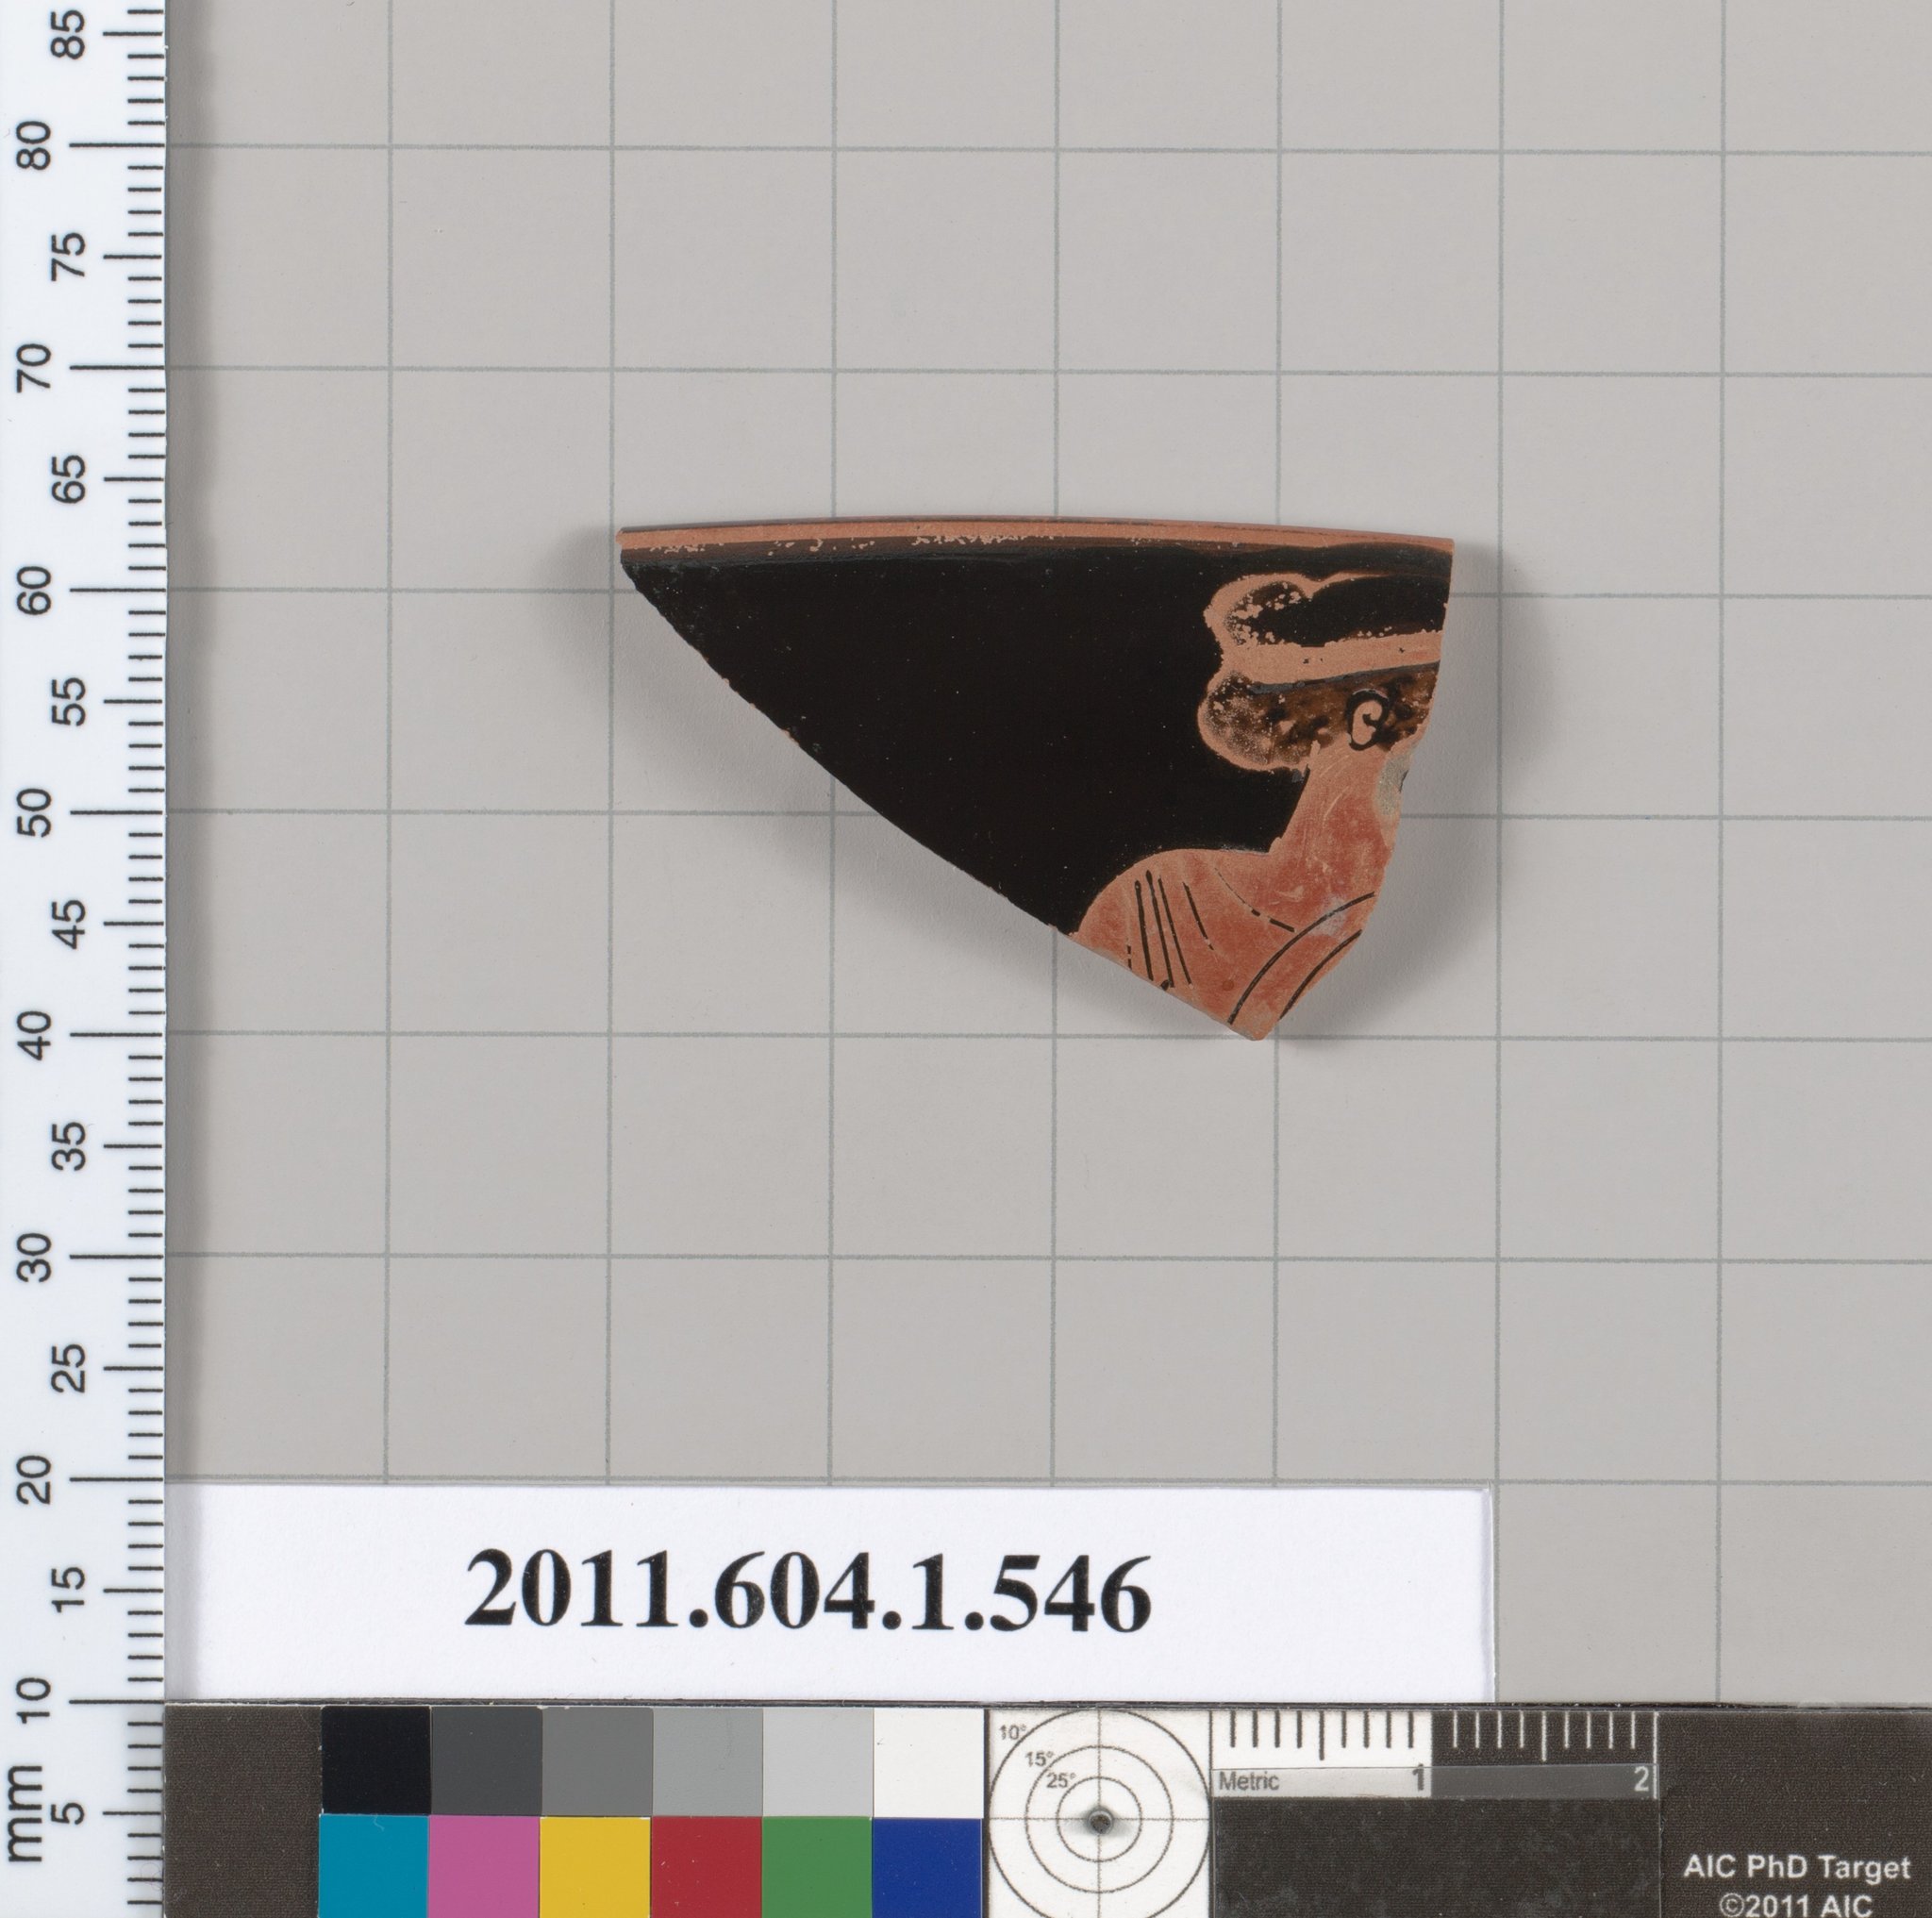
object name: kylix fragment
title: Terracotta rim fragment of a kylix (drinking cup)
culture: greek, attic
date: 480-470 BCE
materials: terracotta